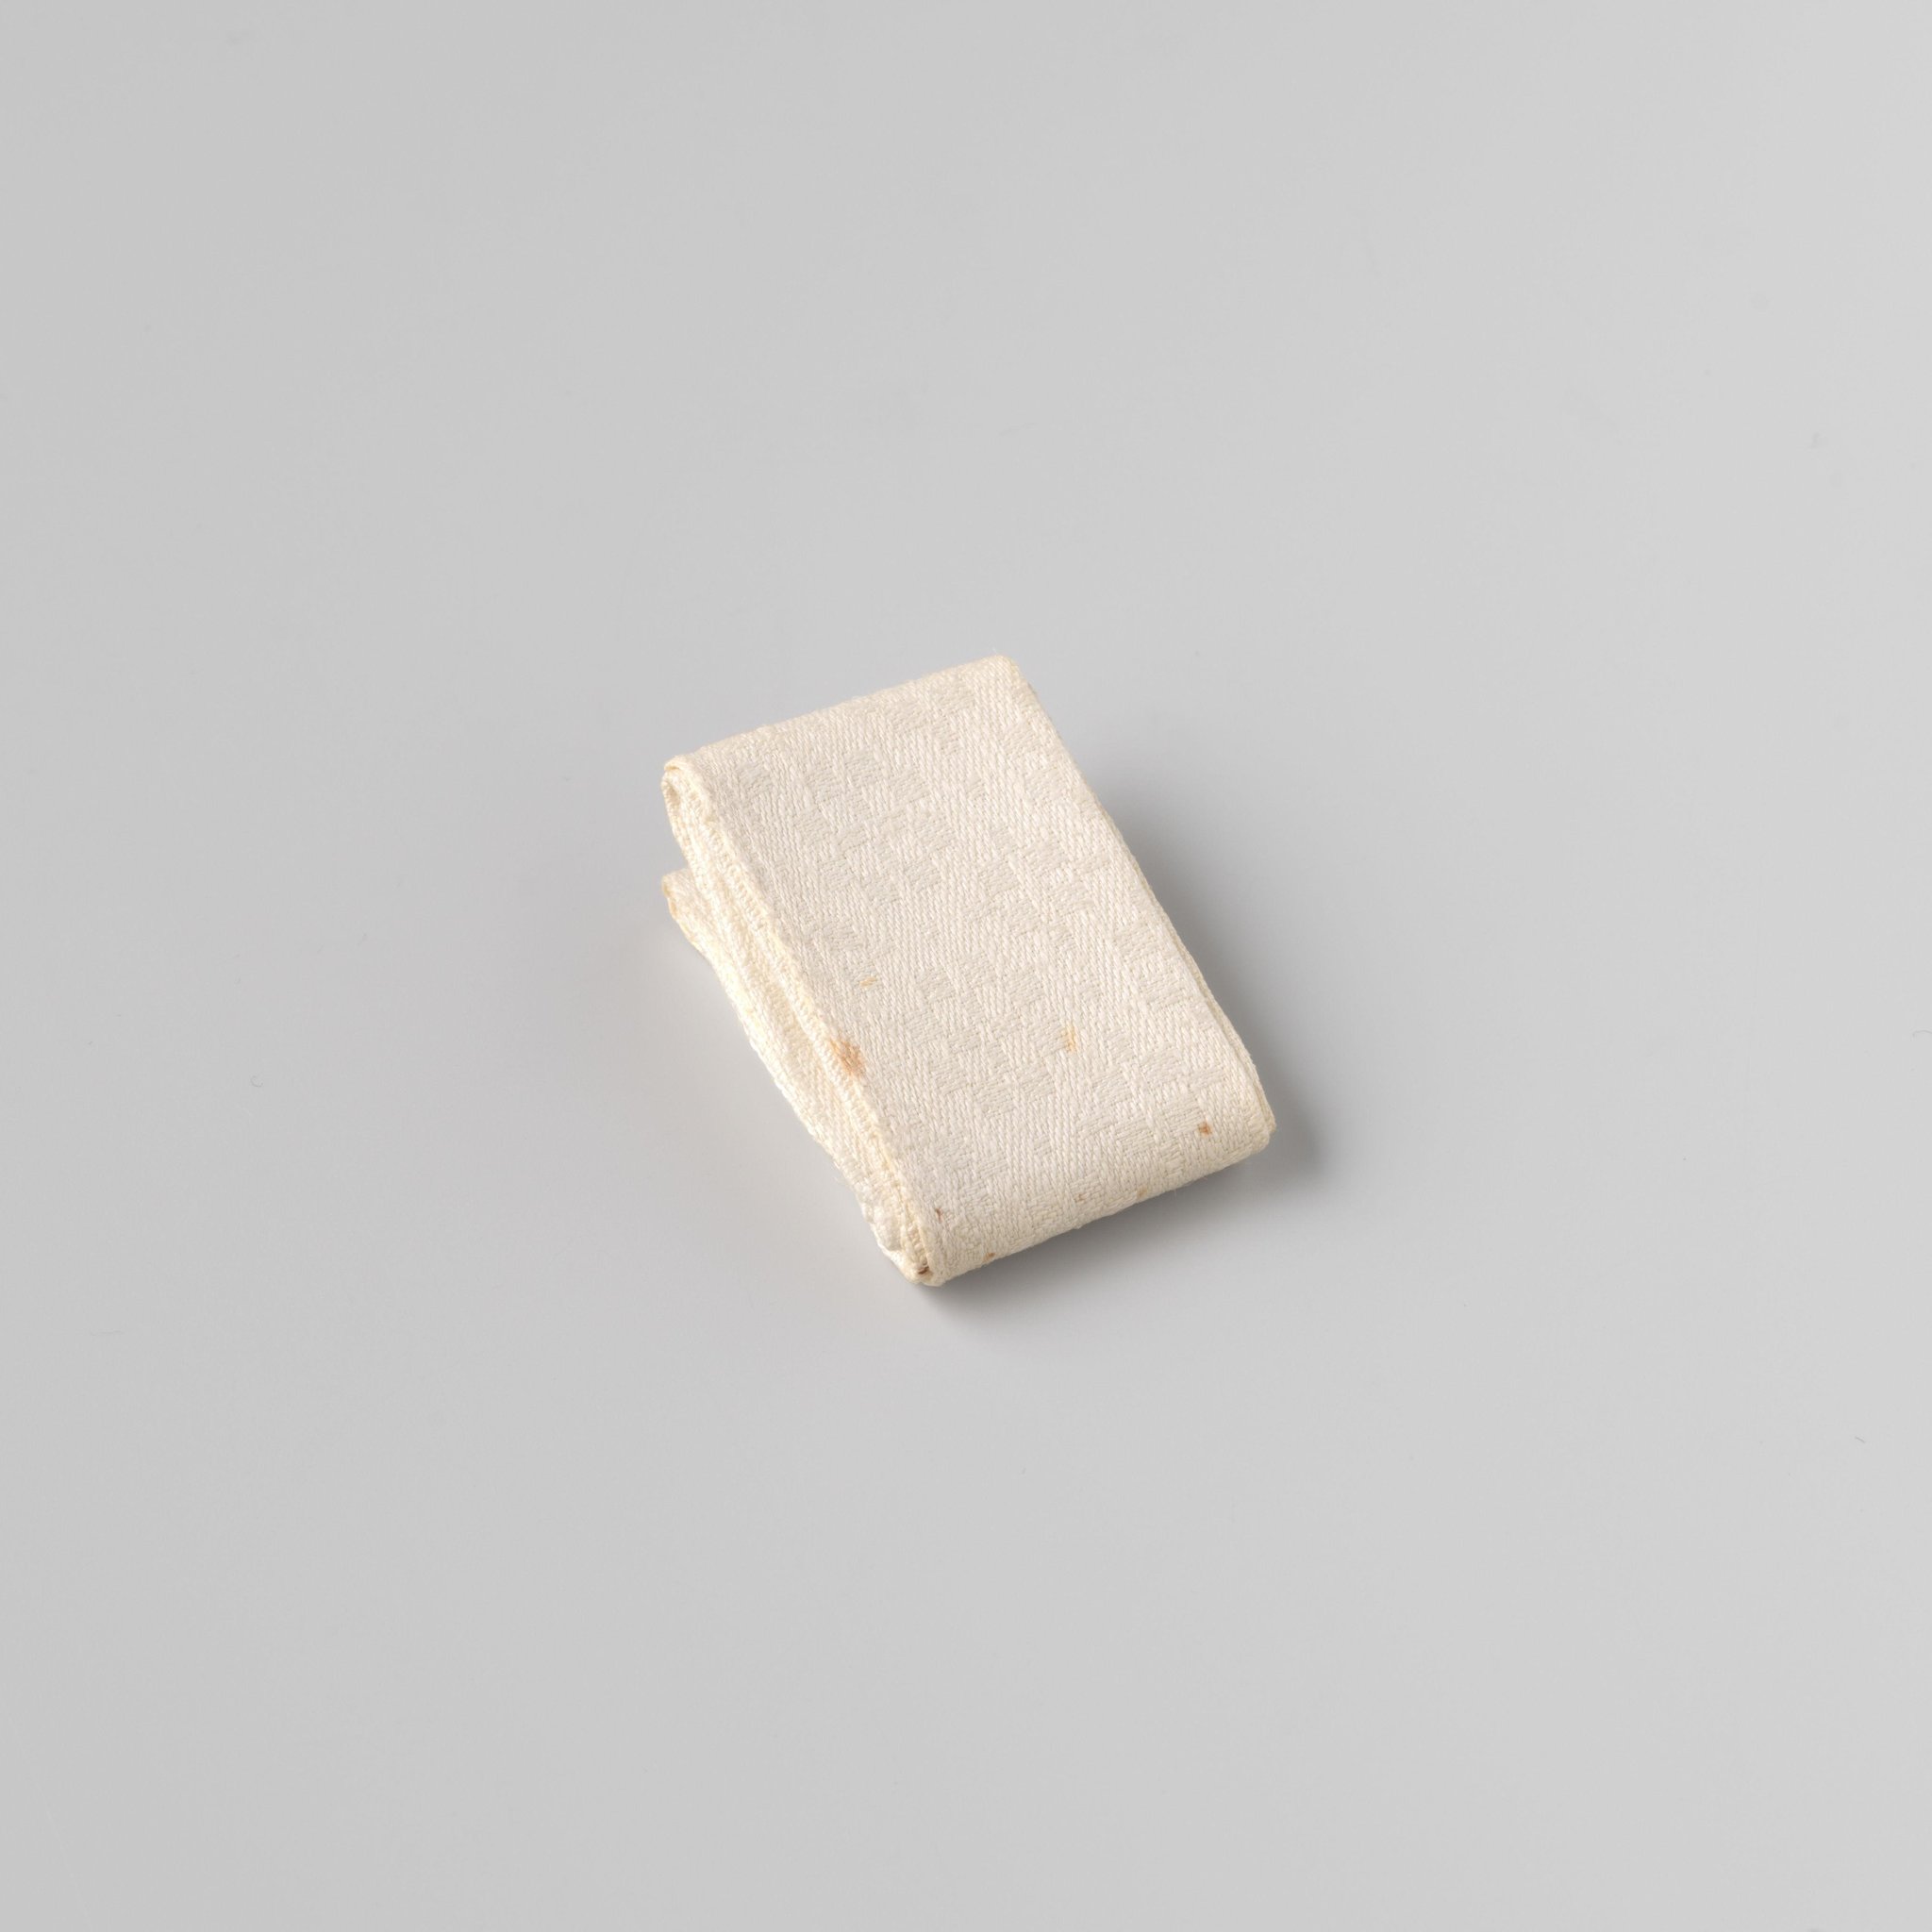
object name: napkin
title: Linnen servet van damastweefsel met pellenpatroon (motief II), aan vier zijden omzoomd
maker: Anonymous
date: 1690-1710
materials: linen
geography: amsterdam